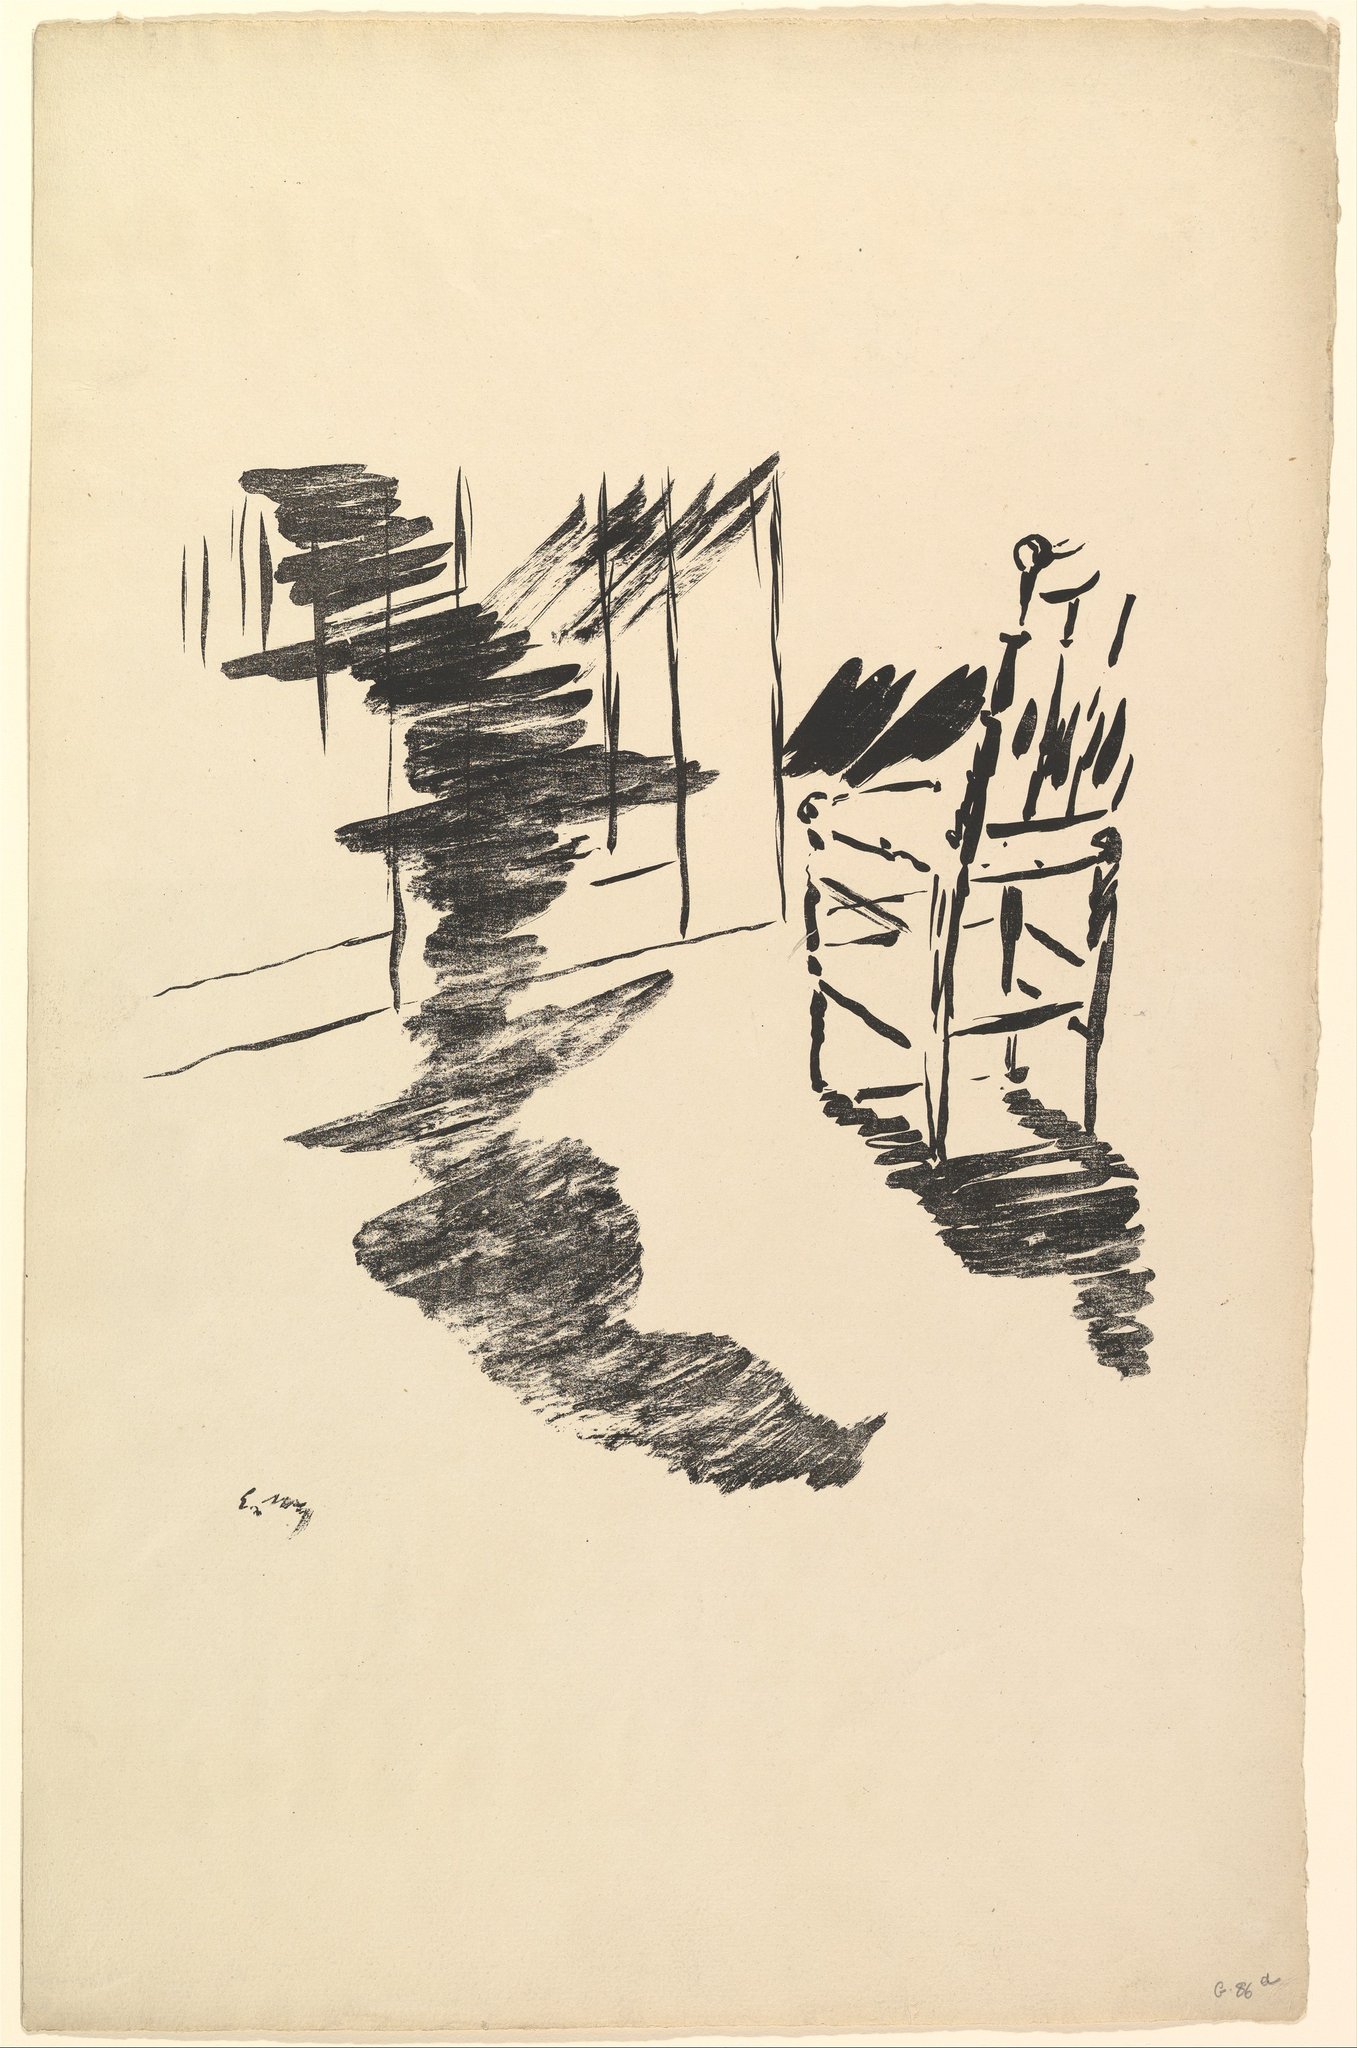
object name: print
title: The Shadow that Lies Floating on the Floor, from "The Raven" by Edgar Allan Poe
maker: édouard manet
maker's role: artist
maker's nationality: french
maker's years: 1832-1883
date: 1875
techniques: lithography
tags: chairs